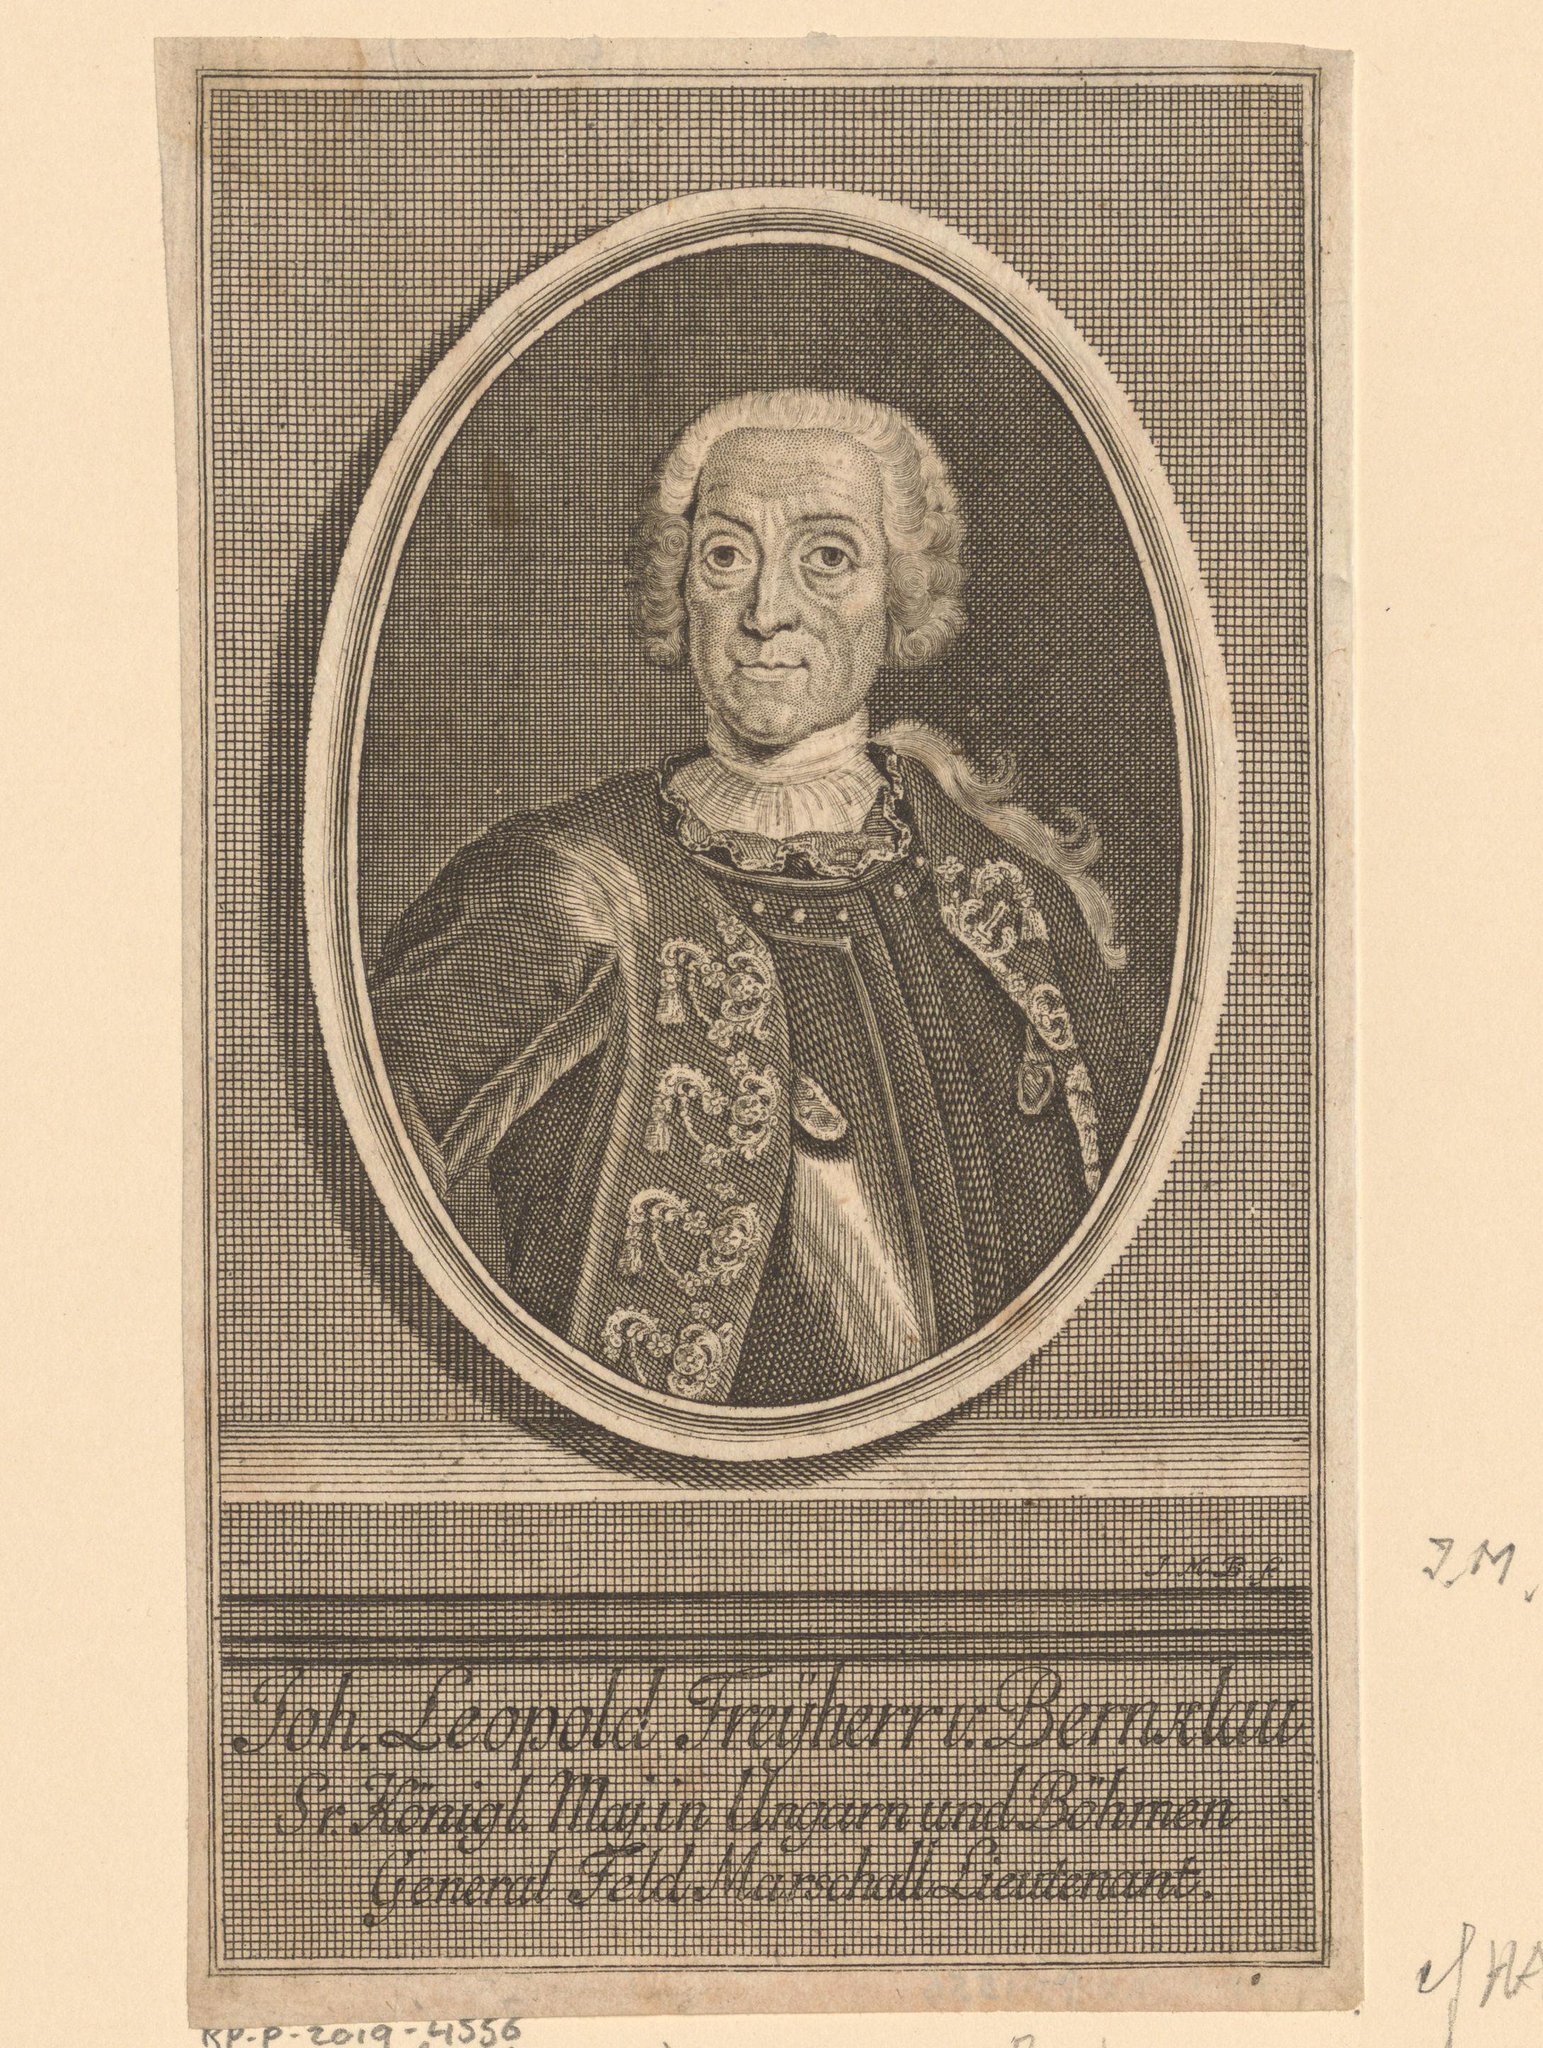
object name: print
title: Portret van Johann Leopold von Bärenklau zu Schönreith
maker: johann martin bernigeroth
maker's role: print maker, publisher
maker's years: 1713-1767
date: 1743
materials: paper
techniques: engraving, etching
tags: historical persons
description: Prent uit: Die Neue Europäische Fama, welche den gegenwärtigen Zustand der vornehmsten Höfe entdecket. S.l.s.n., 1743, dl. 95.